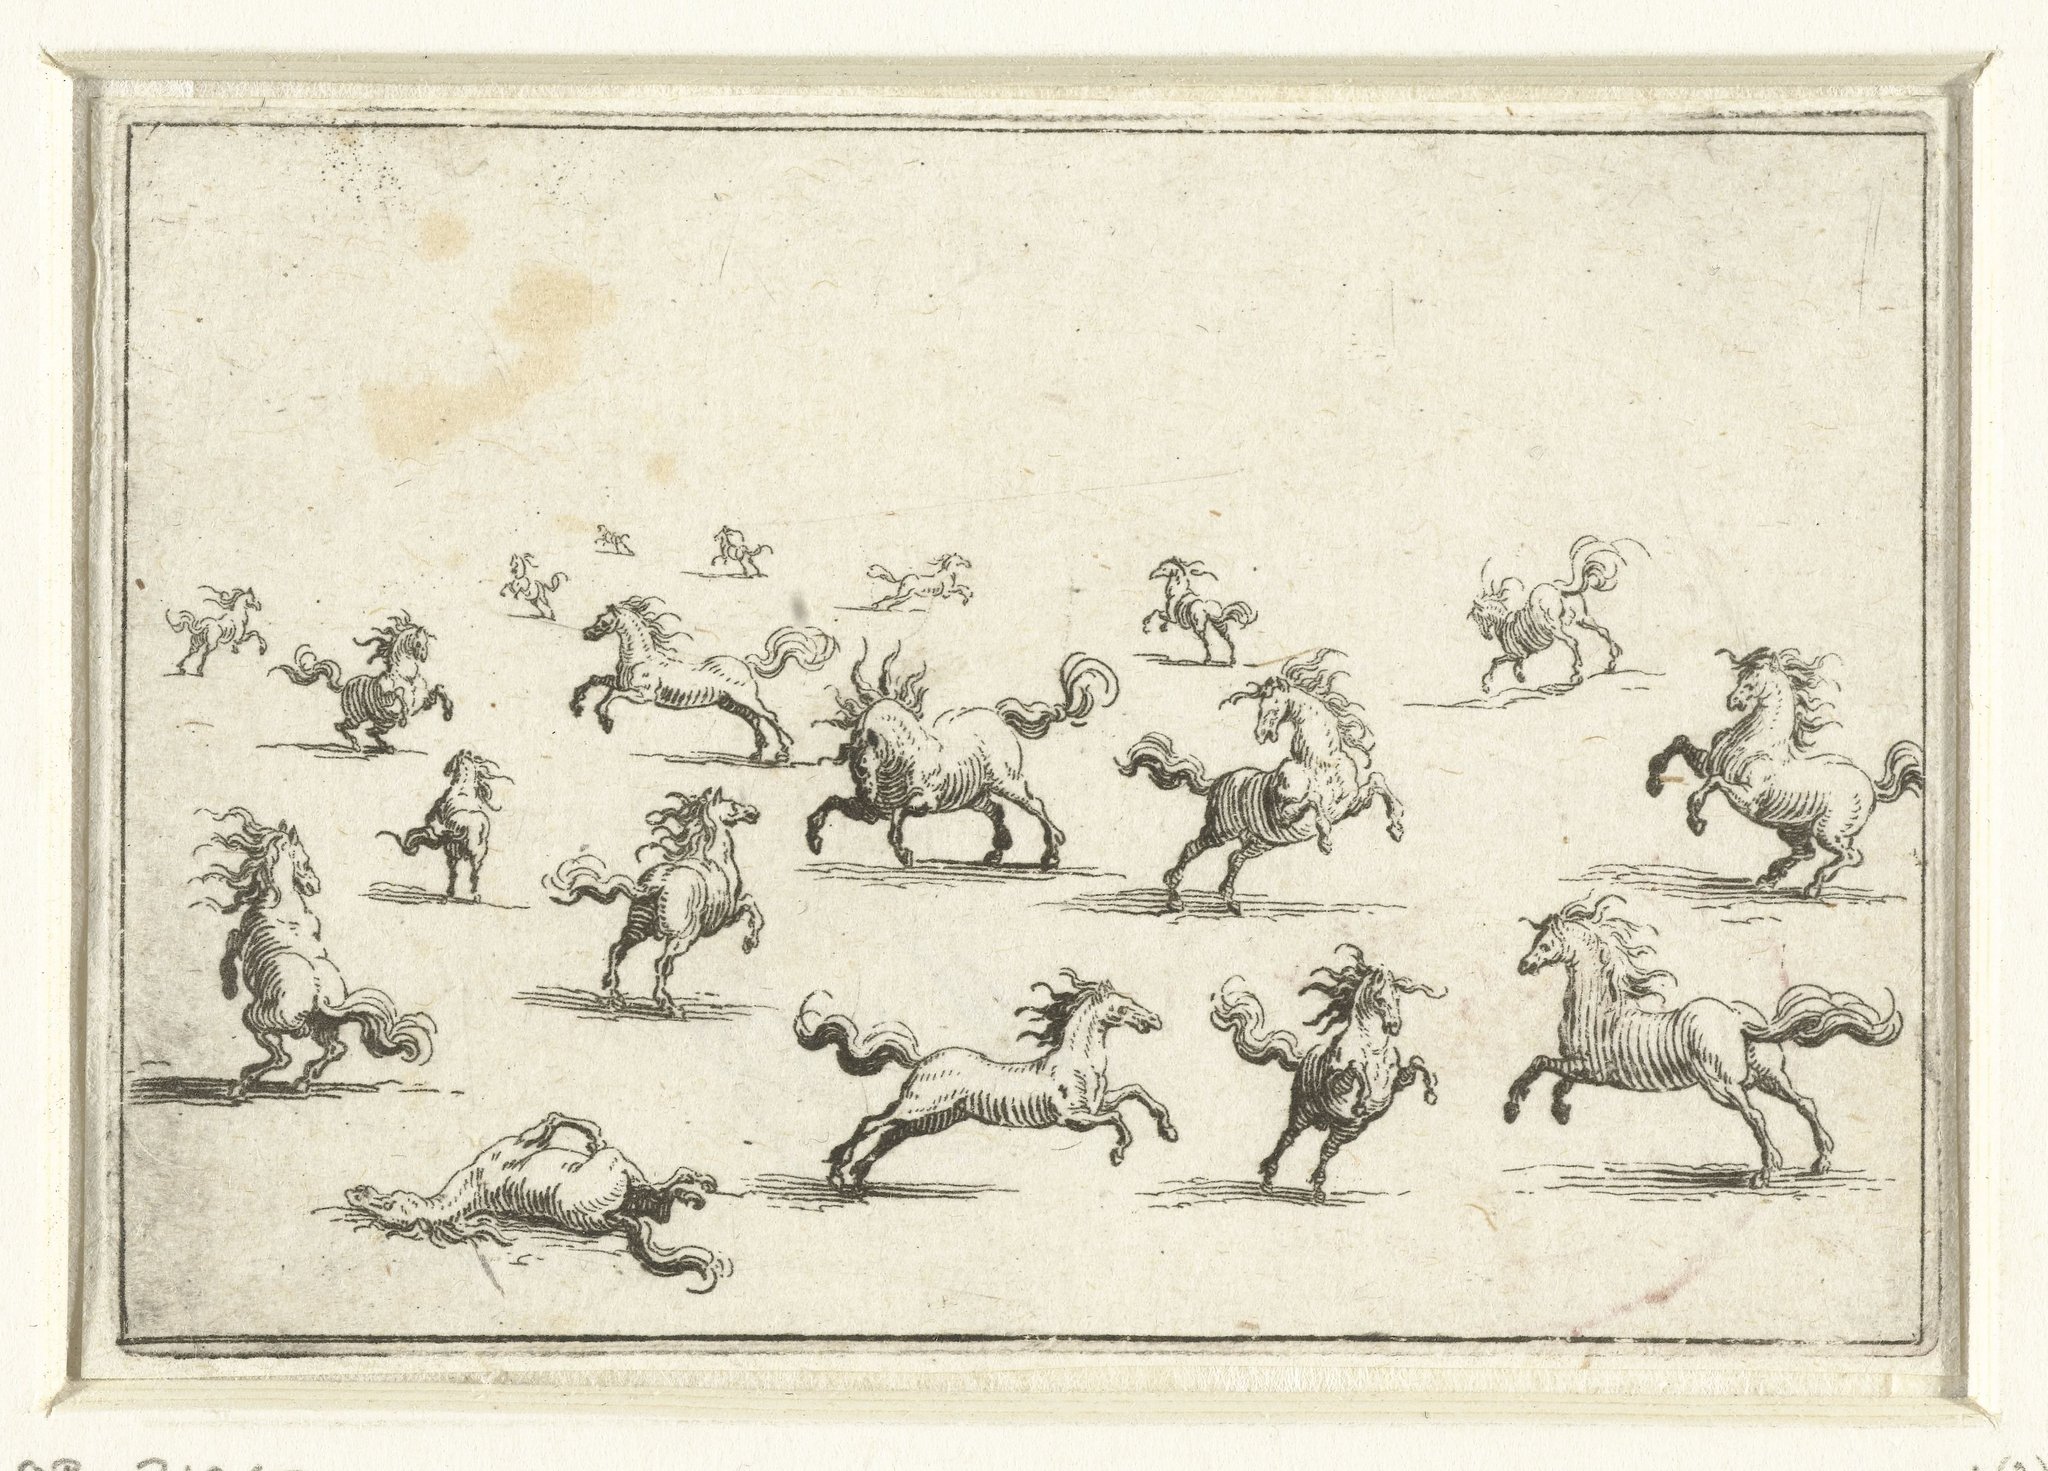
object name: print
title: Capricci di varie Figure di Jacopo Callot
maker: jacques callot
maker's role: draughtsman, print maker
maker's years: 1592-1635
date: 1621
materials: paper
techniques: etching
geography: nancy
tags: rearing (horse in motion), galloping horse, horse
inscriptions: collector's mark: Lugt 240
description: Negentien paarden in verschillende houdingen, o.a. een liggend paard en vele steigerende en galopperende paarden. Deze prent is onderdeel van een serie van 48 prenten (50 incl. titelblad en dedicatieblad) met diverse onderwerpen (o.a. mannen en vrouwen in verschillende houdingen, landschappen, gebouwen en festiviteiten in Florence). Mogelijk zijn deze prenten bedoeld geweest als tekenvoorbeelden.